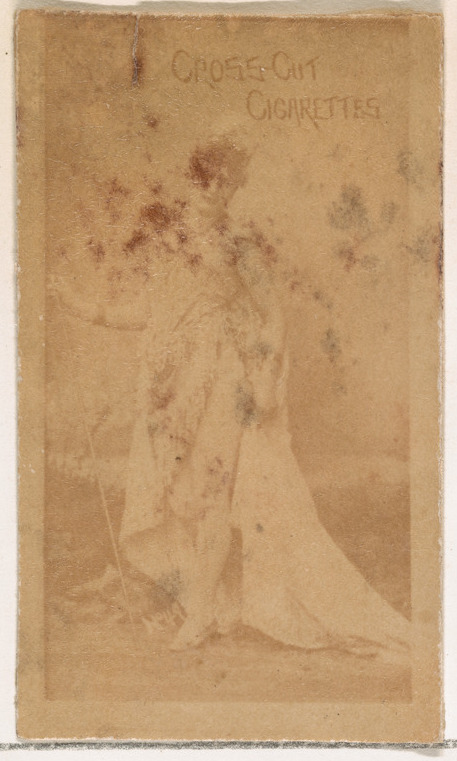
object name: print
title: Card Number 49, from the Actors and Actresses series (N145-1) issued by Duke Sons & Co. to promote Cross Cut Cigarettes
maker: w. duke, sons & co.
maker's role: publisher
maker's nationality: american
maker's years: 1870-1920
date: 1880-1889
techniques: albumen silver print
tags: portraits,women,actresses